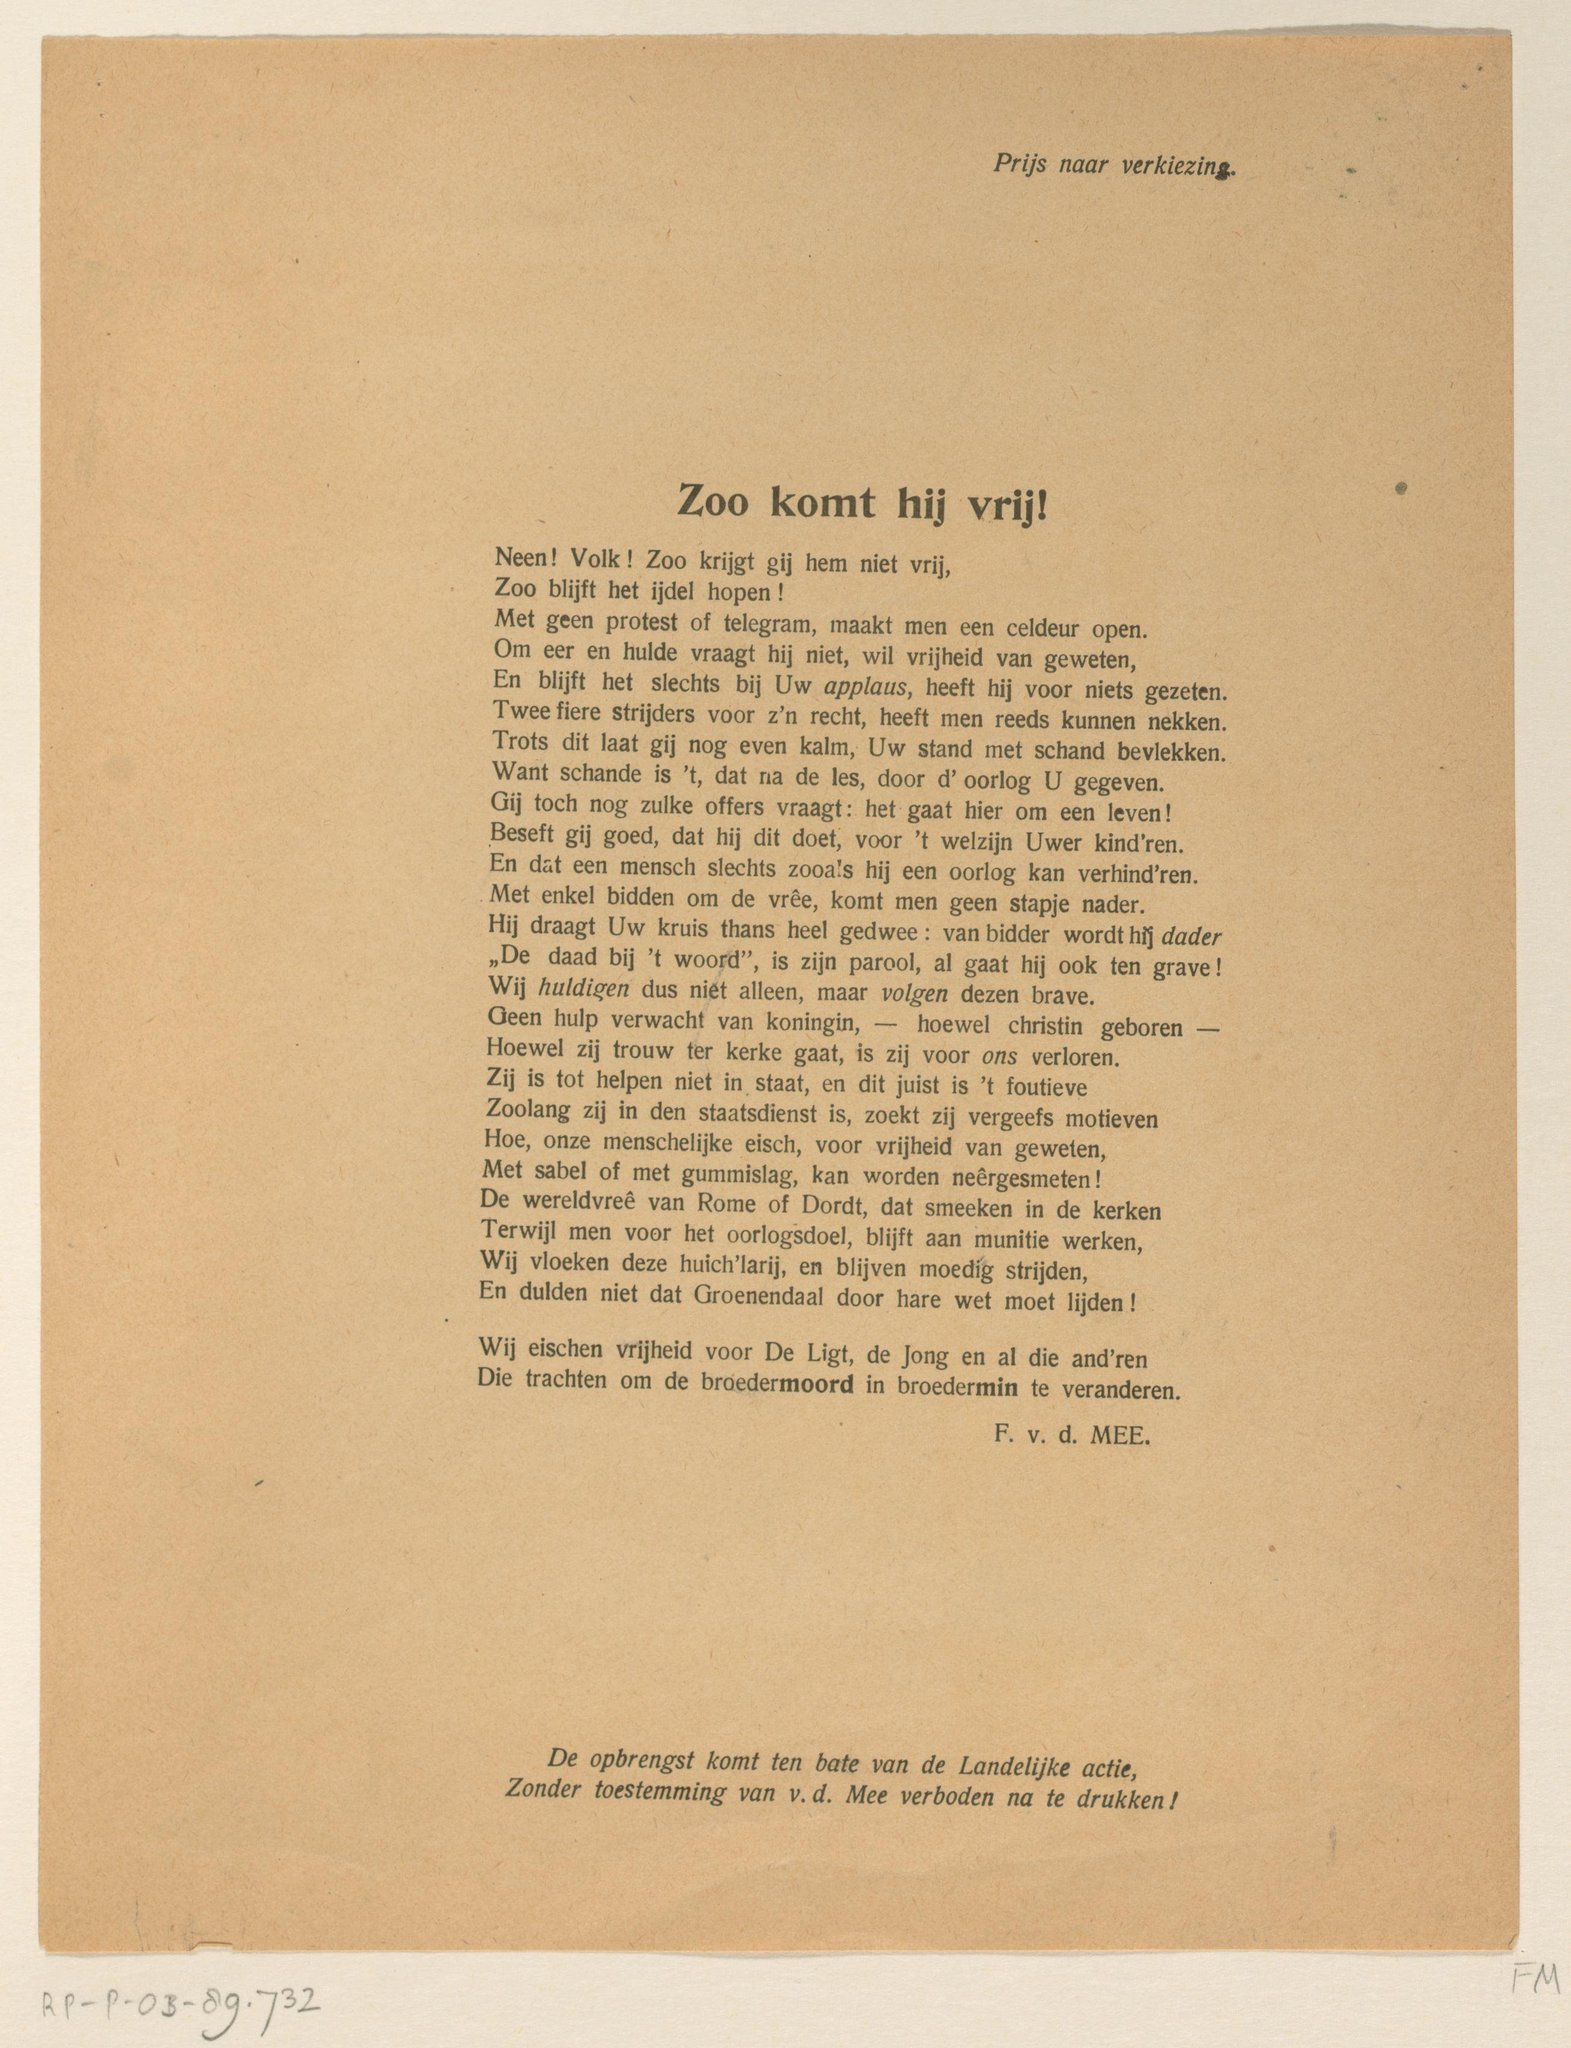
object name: text sheet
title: Zoo komt hij vrij!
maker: f. v.d. mee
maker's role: schrijver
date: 1921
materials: paper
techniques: printed materials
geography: netherlands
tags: bart de ligt, albert andries de jong, herman groenendaal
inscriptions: collector's mark: Lugt 2228, inscription: ‘voor Mevr Hoop Scheffer’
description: Pamflet tegen de veroordeling van Bart de Ligt en Albert de Jong tot één maand gevangenisstraf voor hun uitspraken bij een protestbijeenkomst tegen de gevangenisstraf van de anarchistische dienstweigeraar Herman Groenendaal. Blad op één zijde bedrukt met tekst geschreven door F. v.d. Mee.